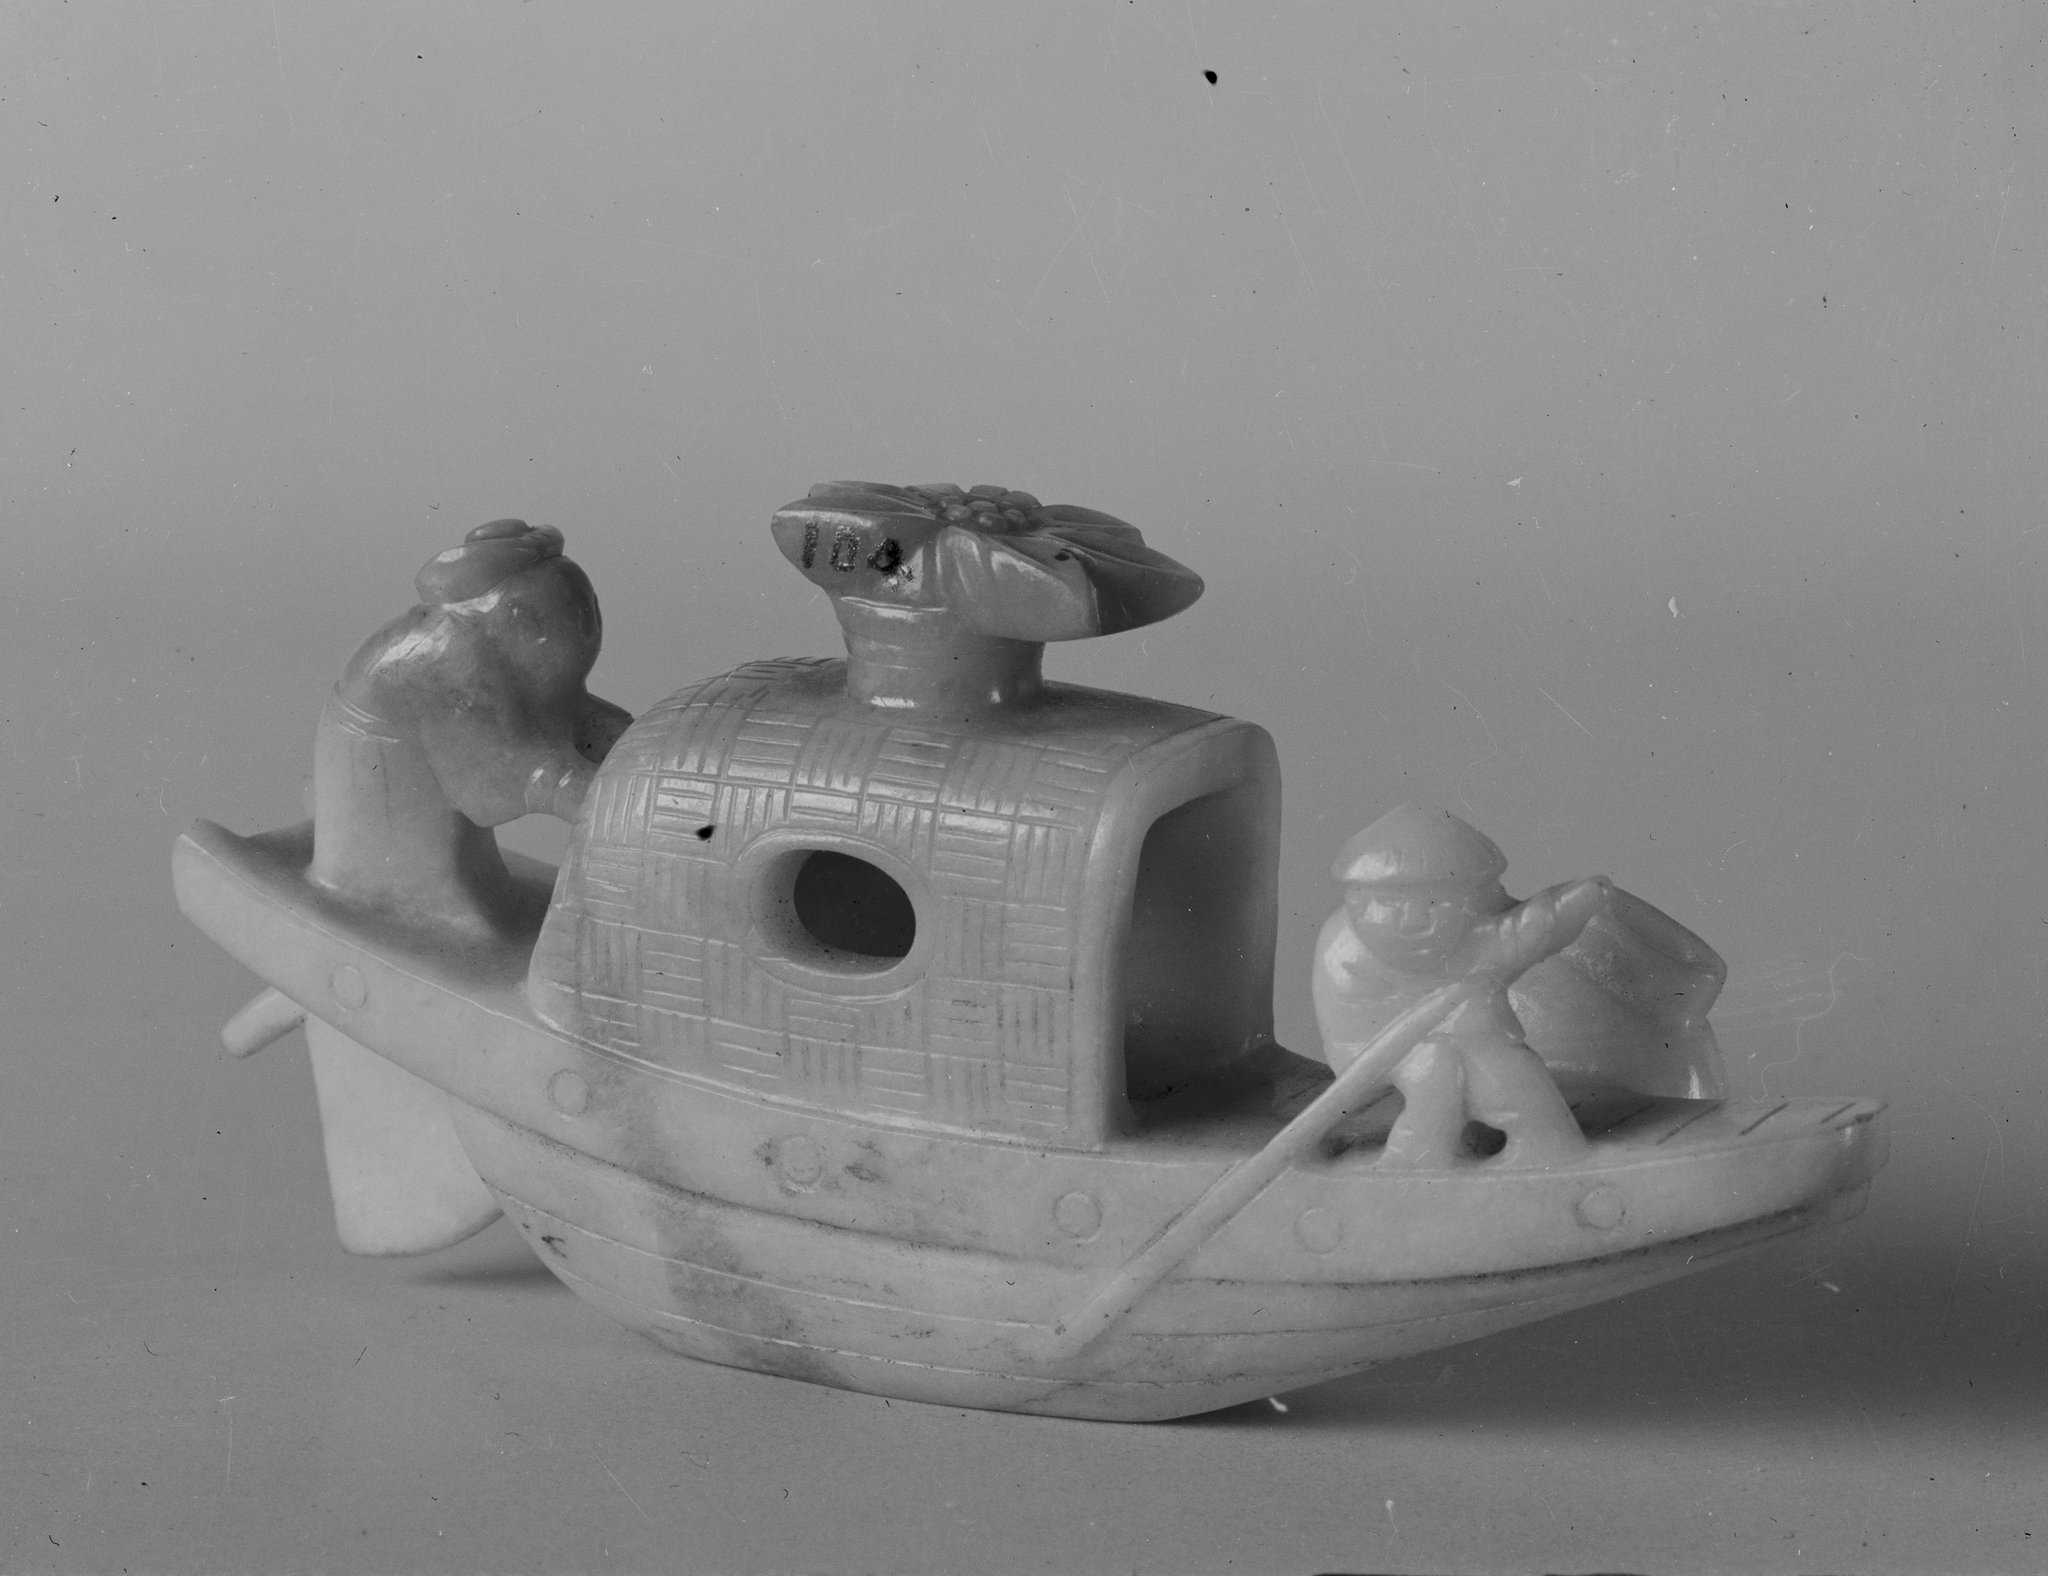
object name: boat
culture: chinese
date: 1801-1900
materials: jade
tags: men,women,boats